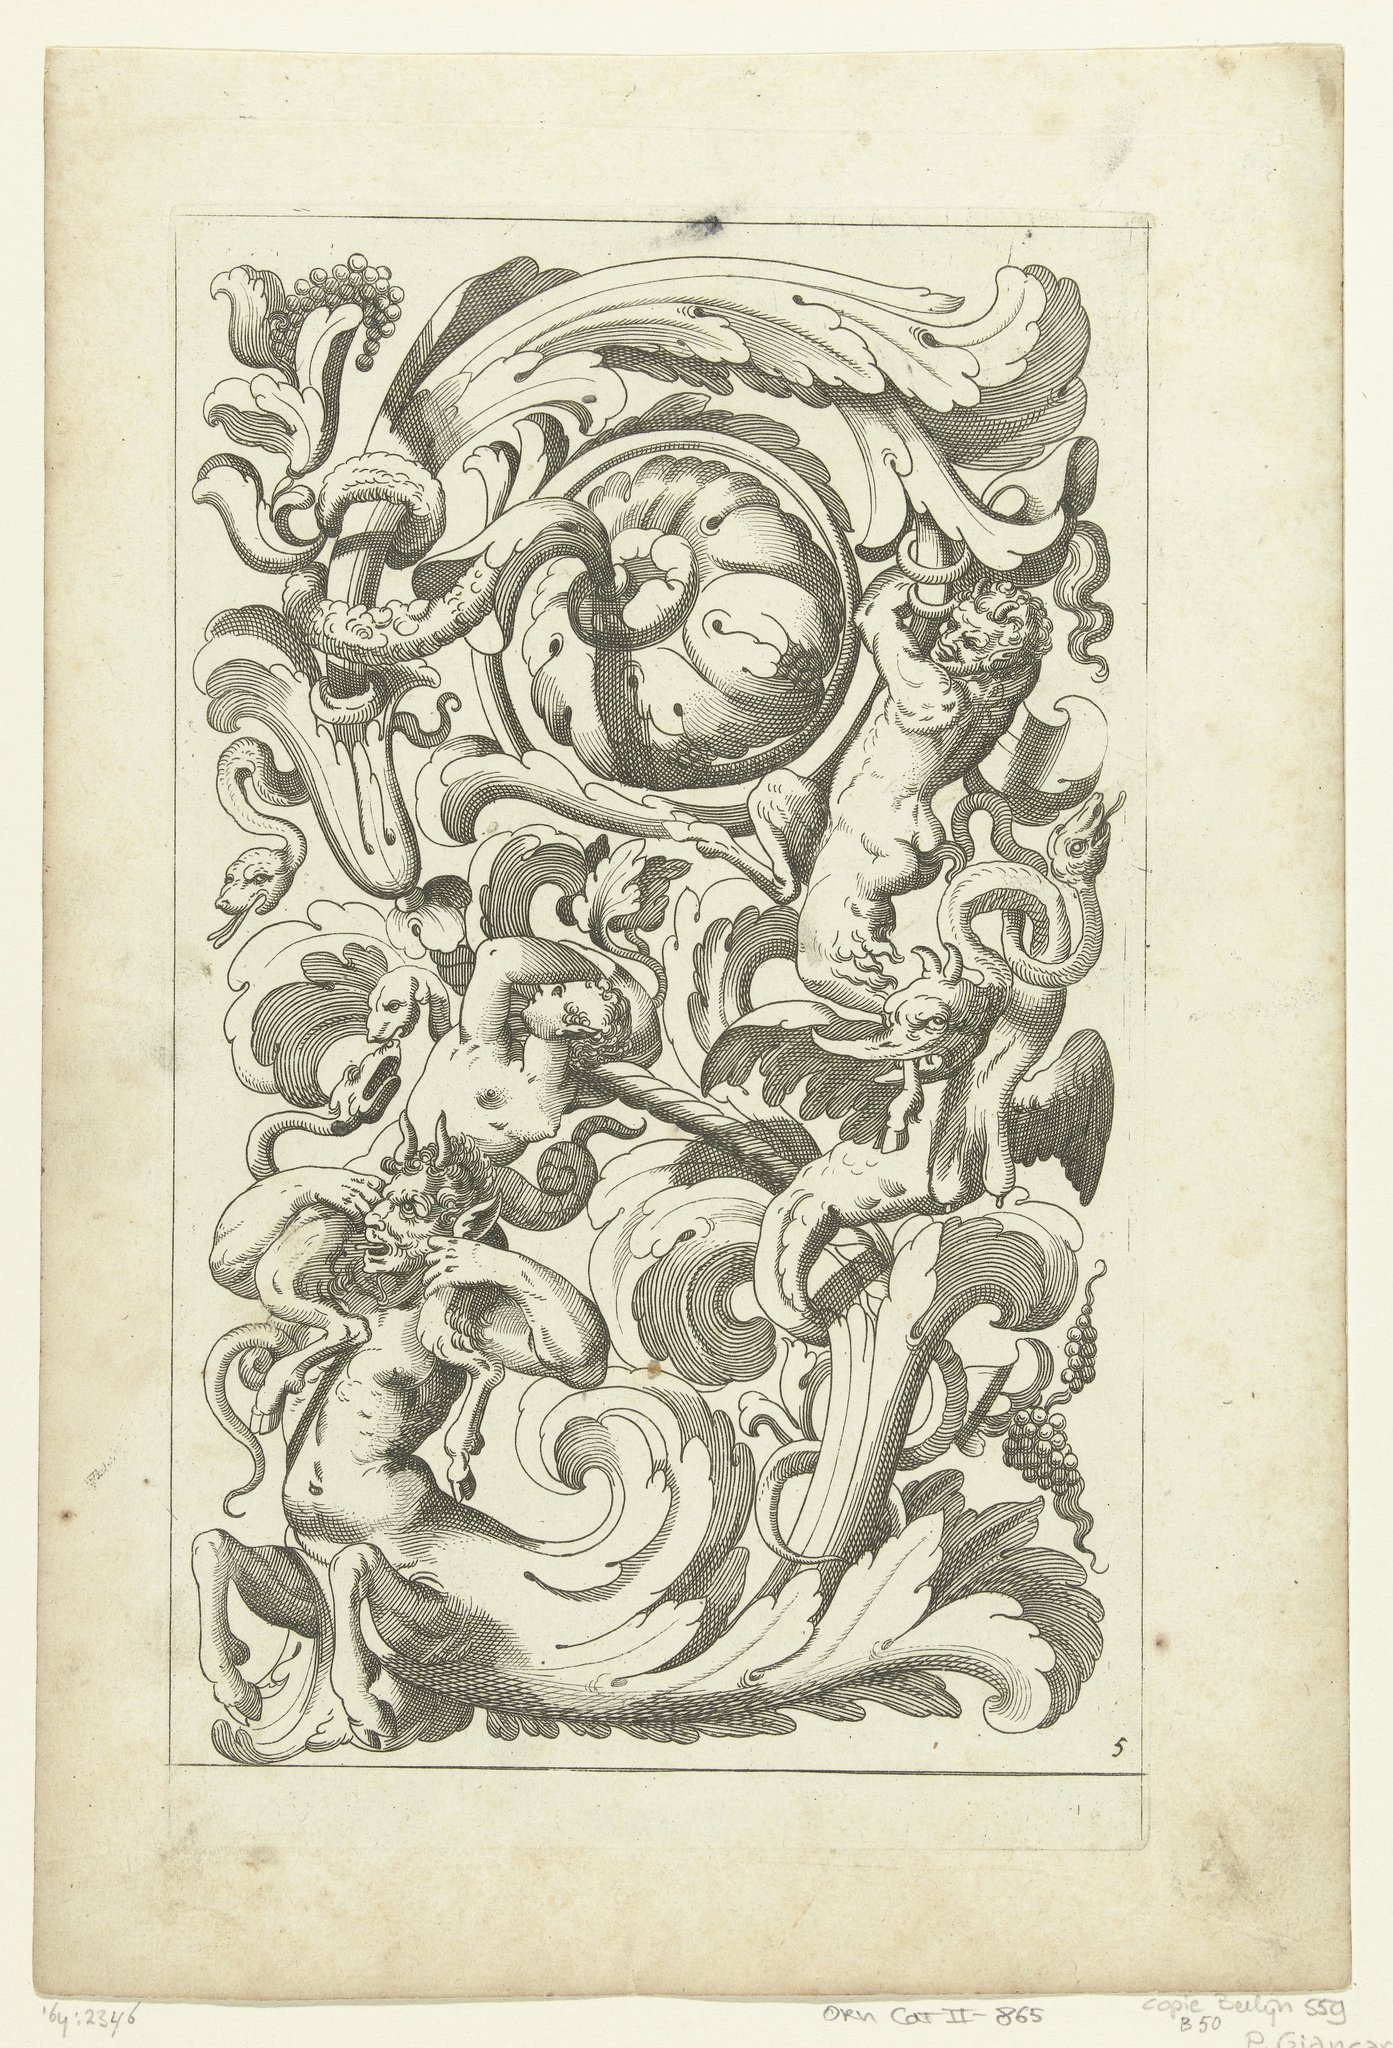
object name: print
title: Sater wiens lichaam uitloopt in een bladrank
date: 1655-1657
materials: paper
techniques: etching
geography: paris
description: De sater linksonder draagt een vrouwelijke sater op zijn schouders, rechtsboven hangt een sater aan een bladrank. Uit serie van 10 bladen met ontwerpen voor verticale panelen met bladranken, figuren en dieren; voornamelijk tegenzijdige kopieën van de serie: Disegni Varii Di Polifilo Zancarli.